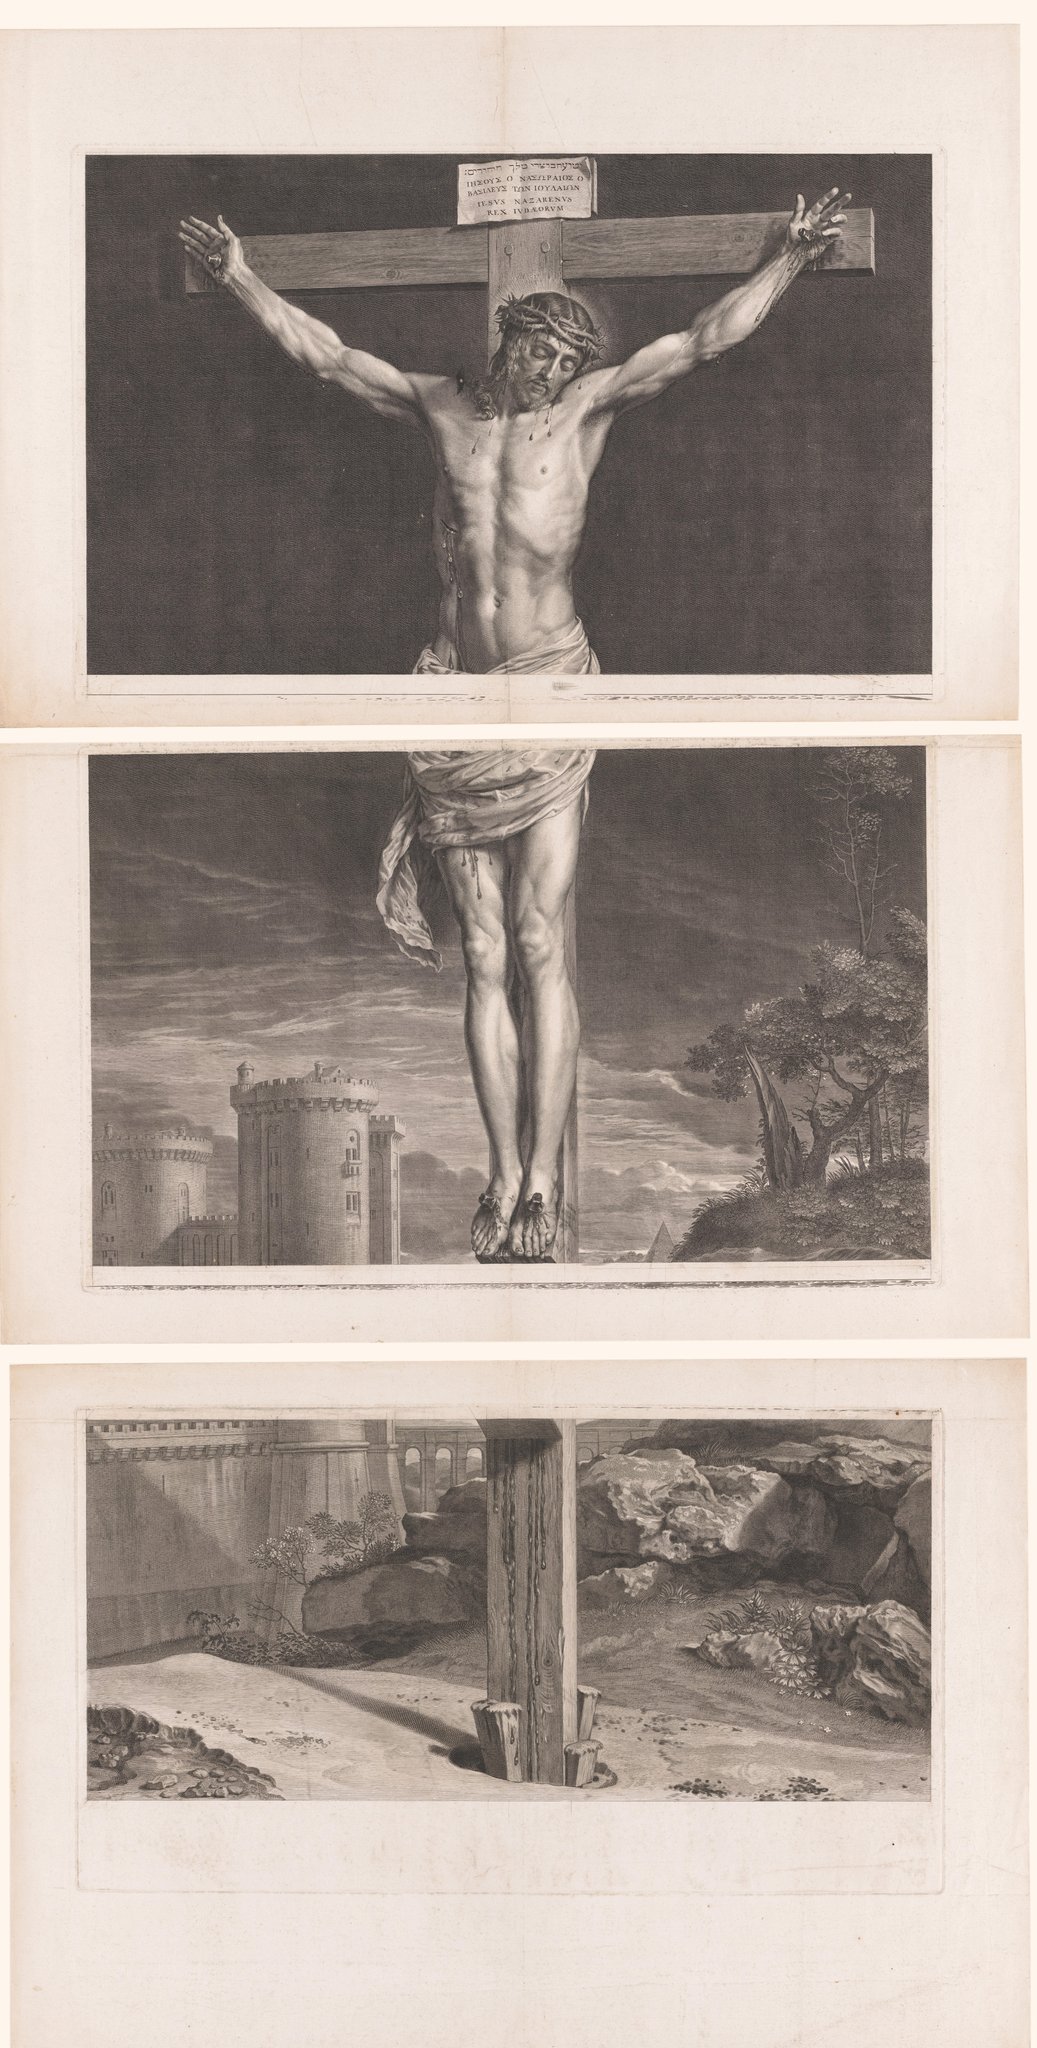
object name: print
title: Kruisiging van Christus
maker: Anonymous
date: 1600-1699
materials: paper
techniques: engraving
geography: france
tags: the crucifixion of christ: christ's death on the cross; golgotha (matthew 27:45-58; mark 15:33-45; luke 23:44-52; john 19:25-38)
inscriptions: collector's mark: Lugt 240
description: Dit object is omwille van een betere presentatie virtueel samengevoegd, maar bestaat fysiek uit losse onderdelen.